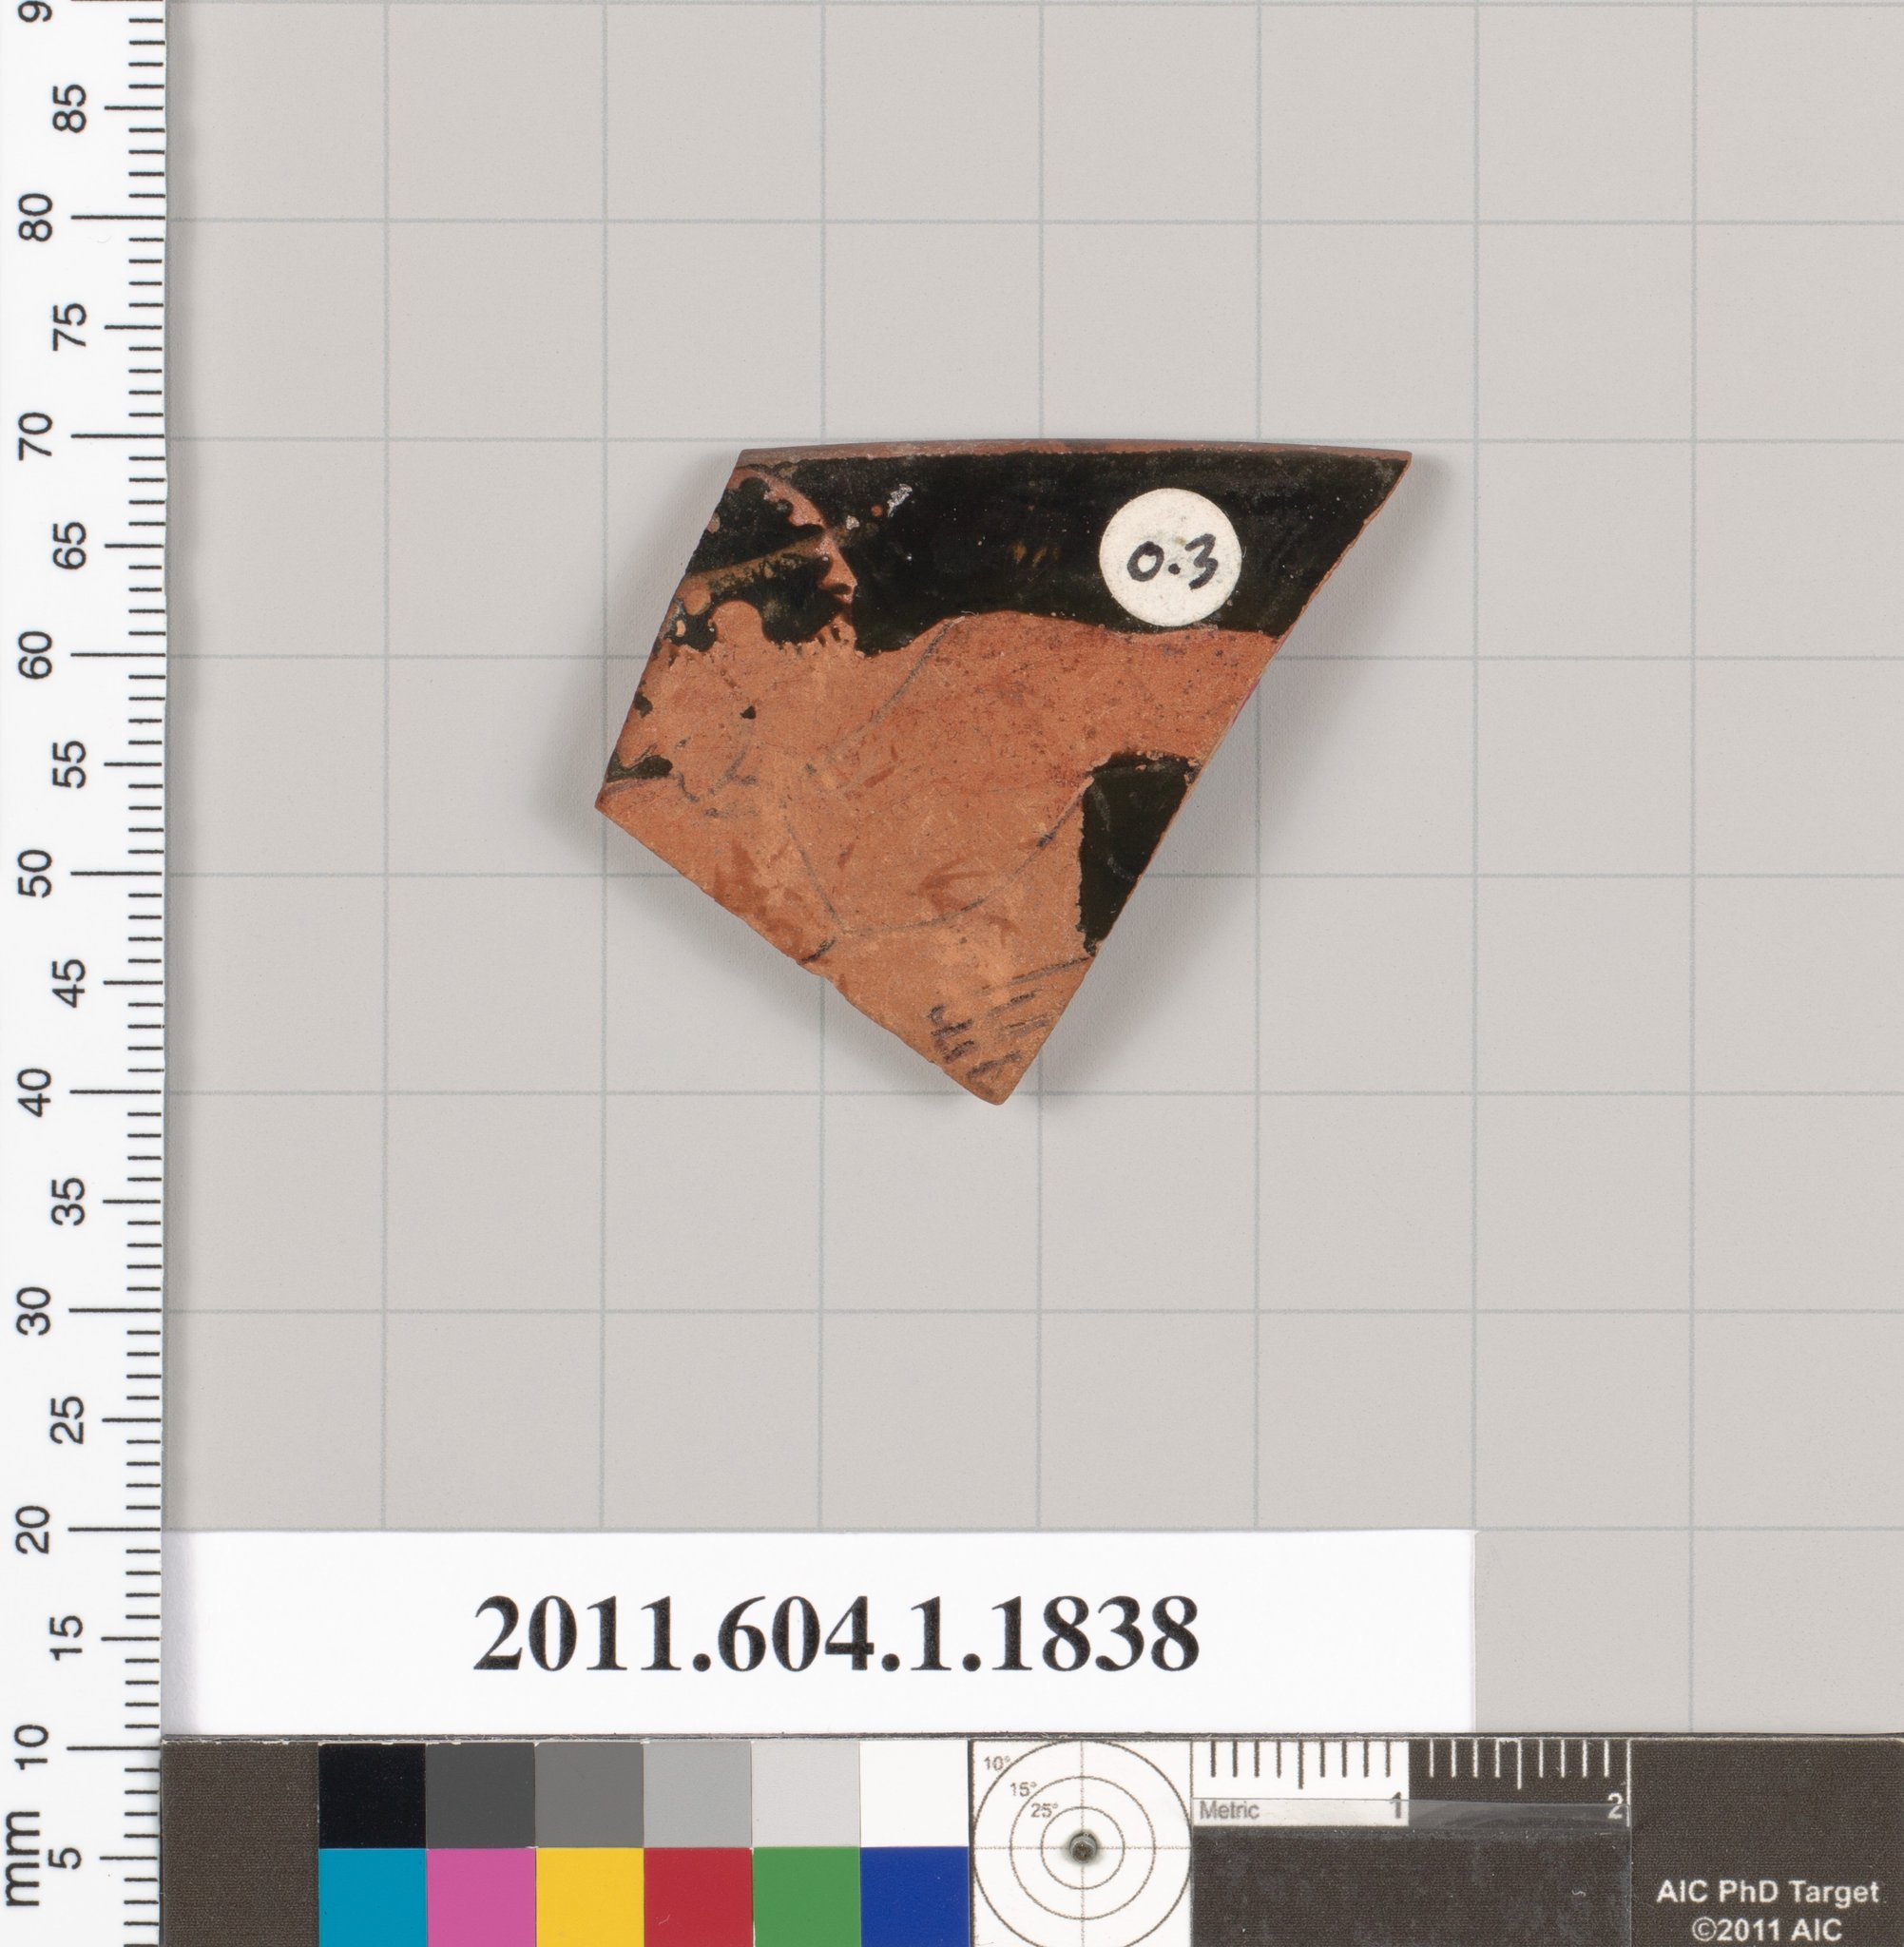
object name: kylix fragment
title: Terracotta rim fragment of a kylix (drinking cup)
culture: greek, attic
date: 500-490 BCE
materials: terracotta